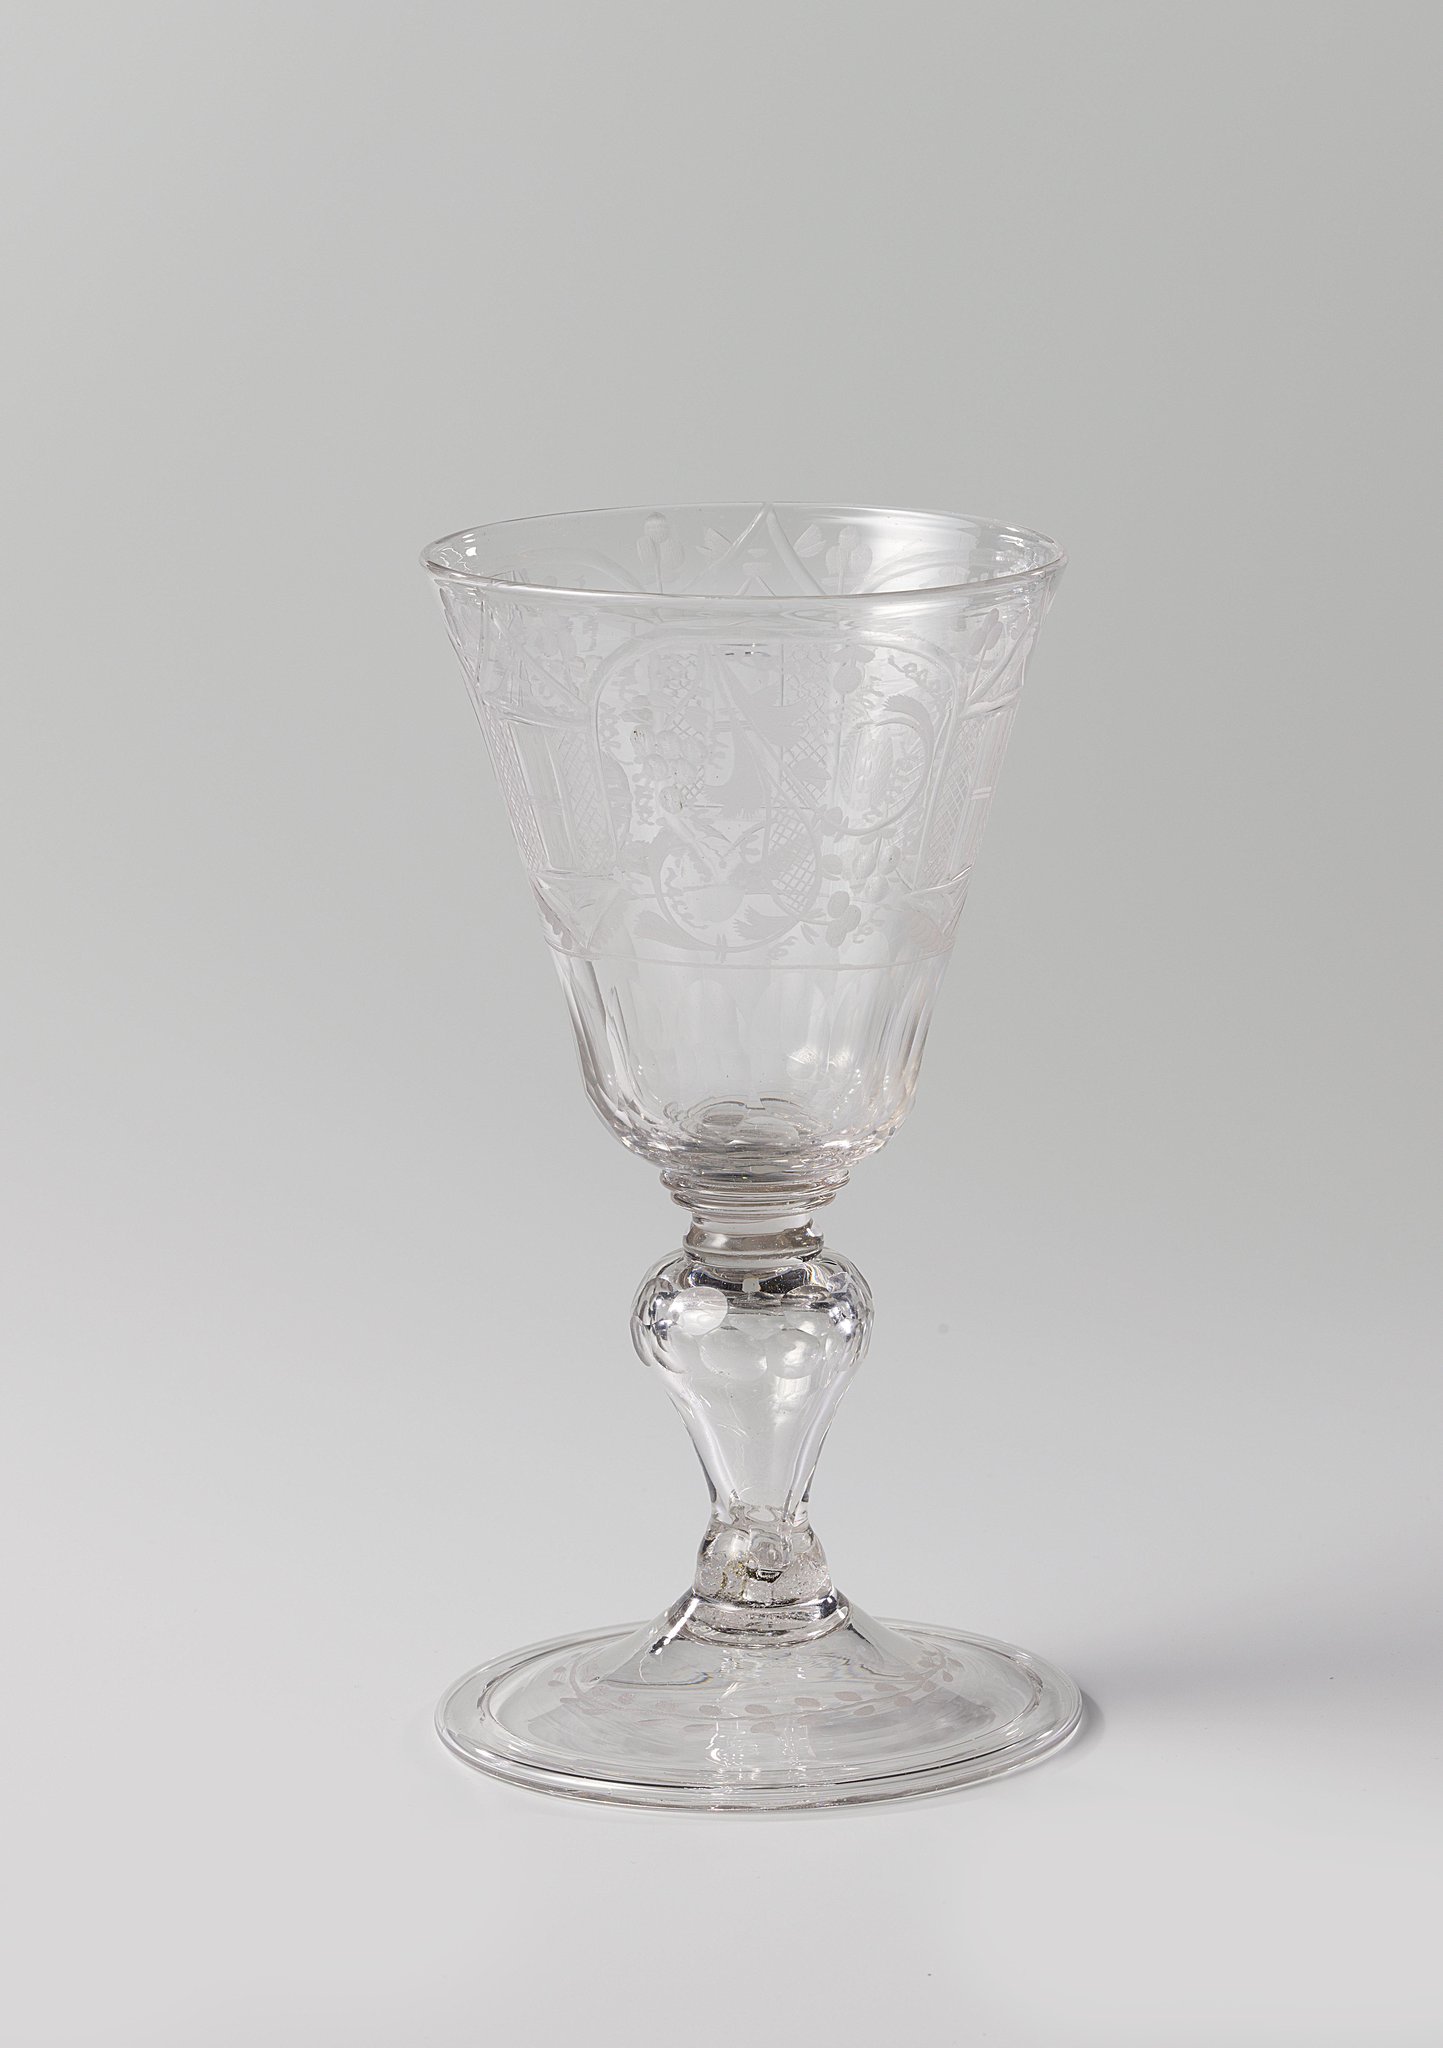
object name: dubbelbokaal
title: Dubbelbokaal met ornamenten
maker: Anonymous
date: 1725-1750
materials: glass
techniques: glassblowing, grinding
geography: bohemia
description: Dubbelbokaal van helder, kleurloos glas. Op de kelk weinig diep ingesneden ornamenten.